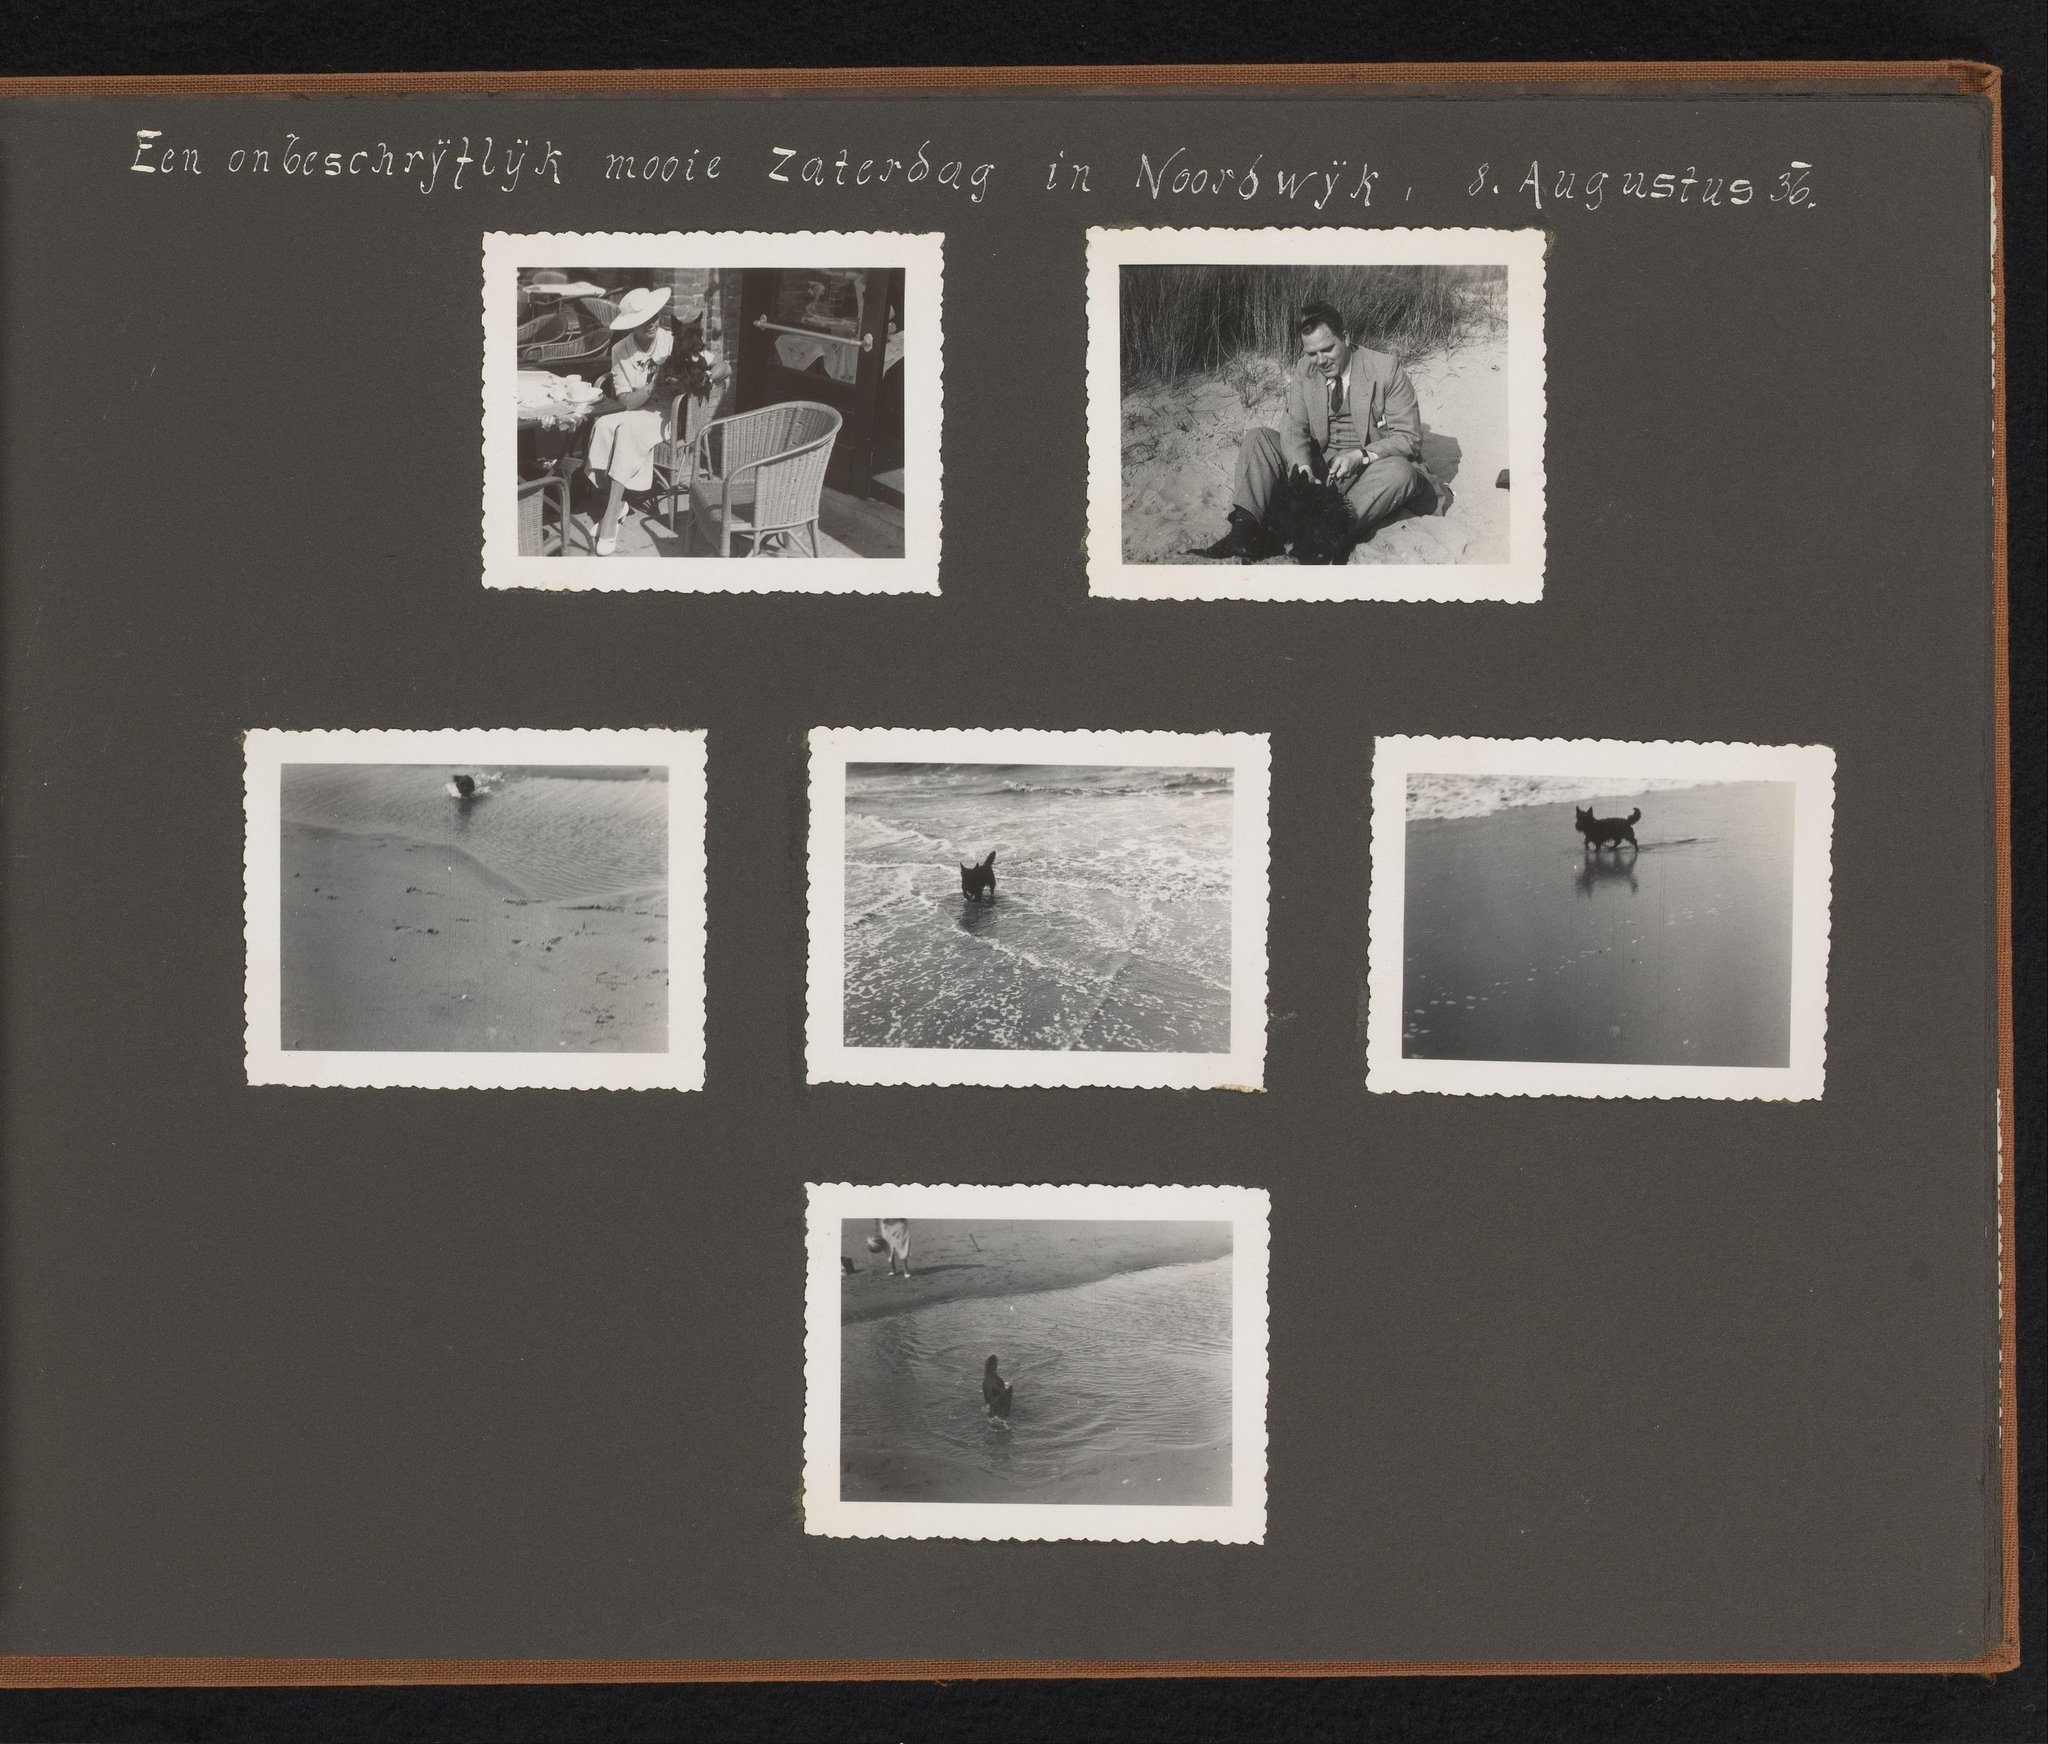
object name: photograph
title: Echtpaar Berti Hoppe en Herman Besselaar met de hond aan het strand te Noordwijk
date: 1936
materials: cardboard, paper, photographic support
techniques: gelatin silver print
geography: noordwijk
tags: herman besselaar, berti hoppe, beach (as place of recreation), walking the dog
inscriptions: date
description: Zes foto's gemaakt tijdens hun bezoek aan Noordwijk. Deze pagina maakt deel uit van een album.